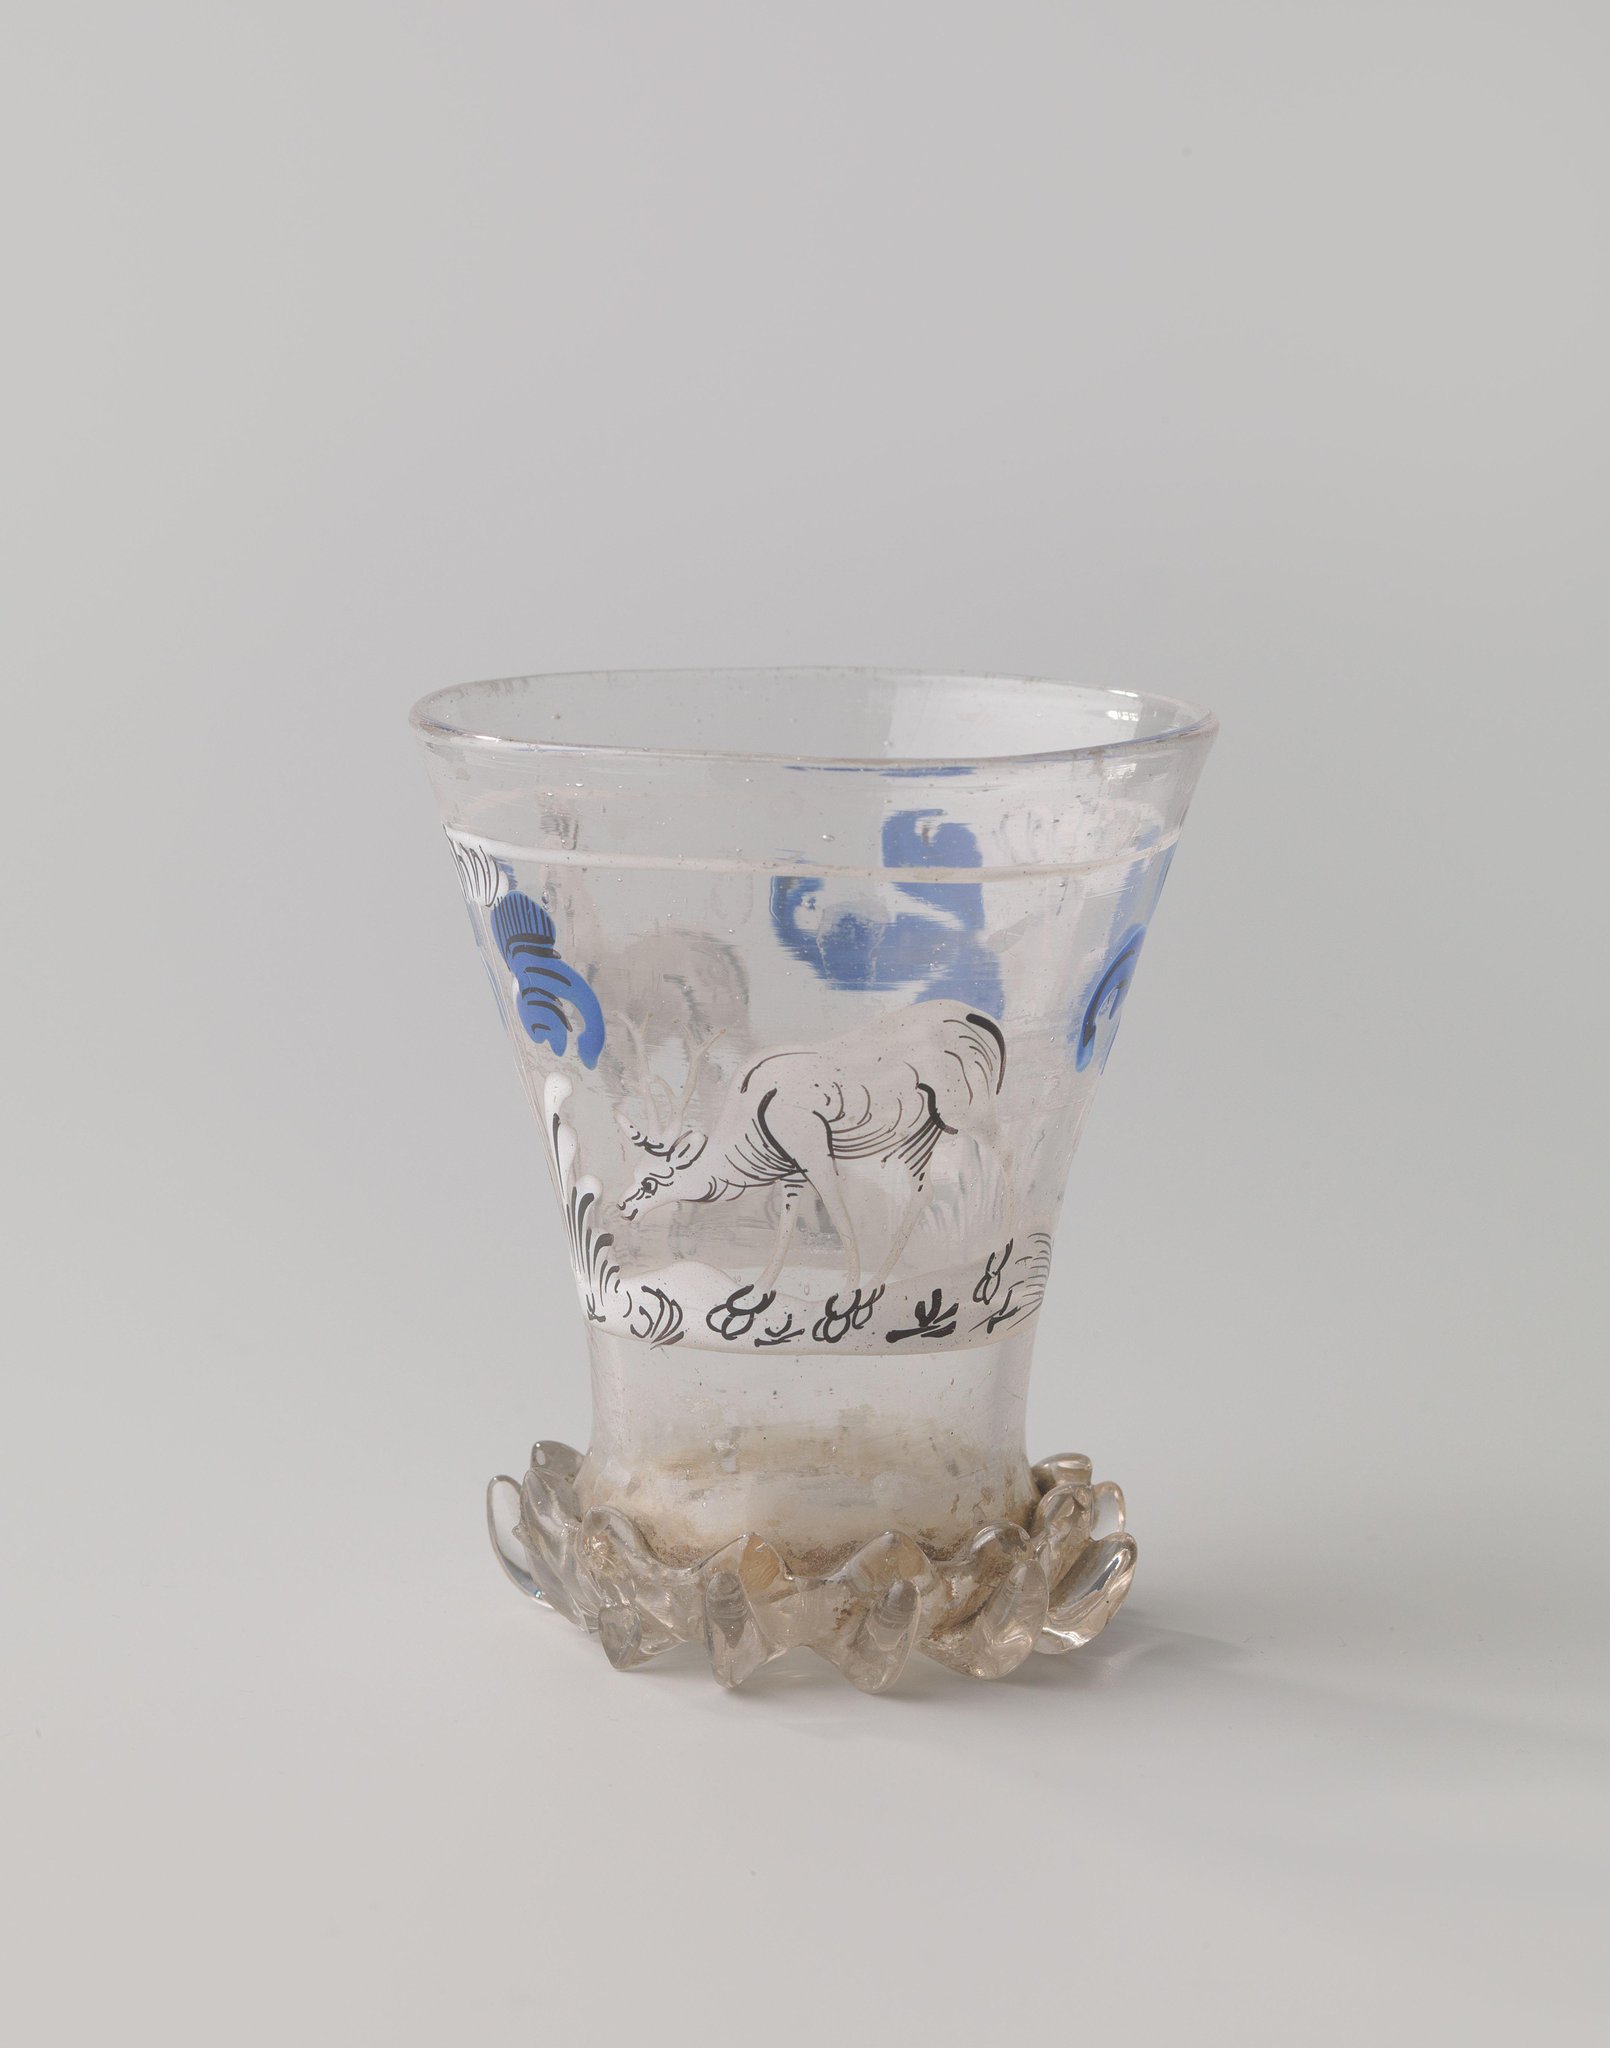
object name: cup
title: Beker met herten en bloemtakken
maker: Anonymous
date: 1700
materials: glass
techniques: glassblowing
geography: central germany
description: Bodem en standring optisch geblazen in stervormig geplaatste ribben. Trechtervormige kelk, waarop in wit, zwart en blauw twee herten op een grasgrond tussen bloemtakken.